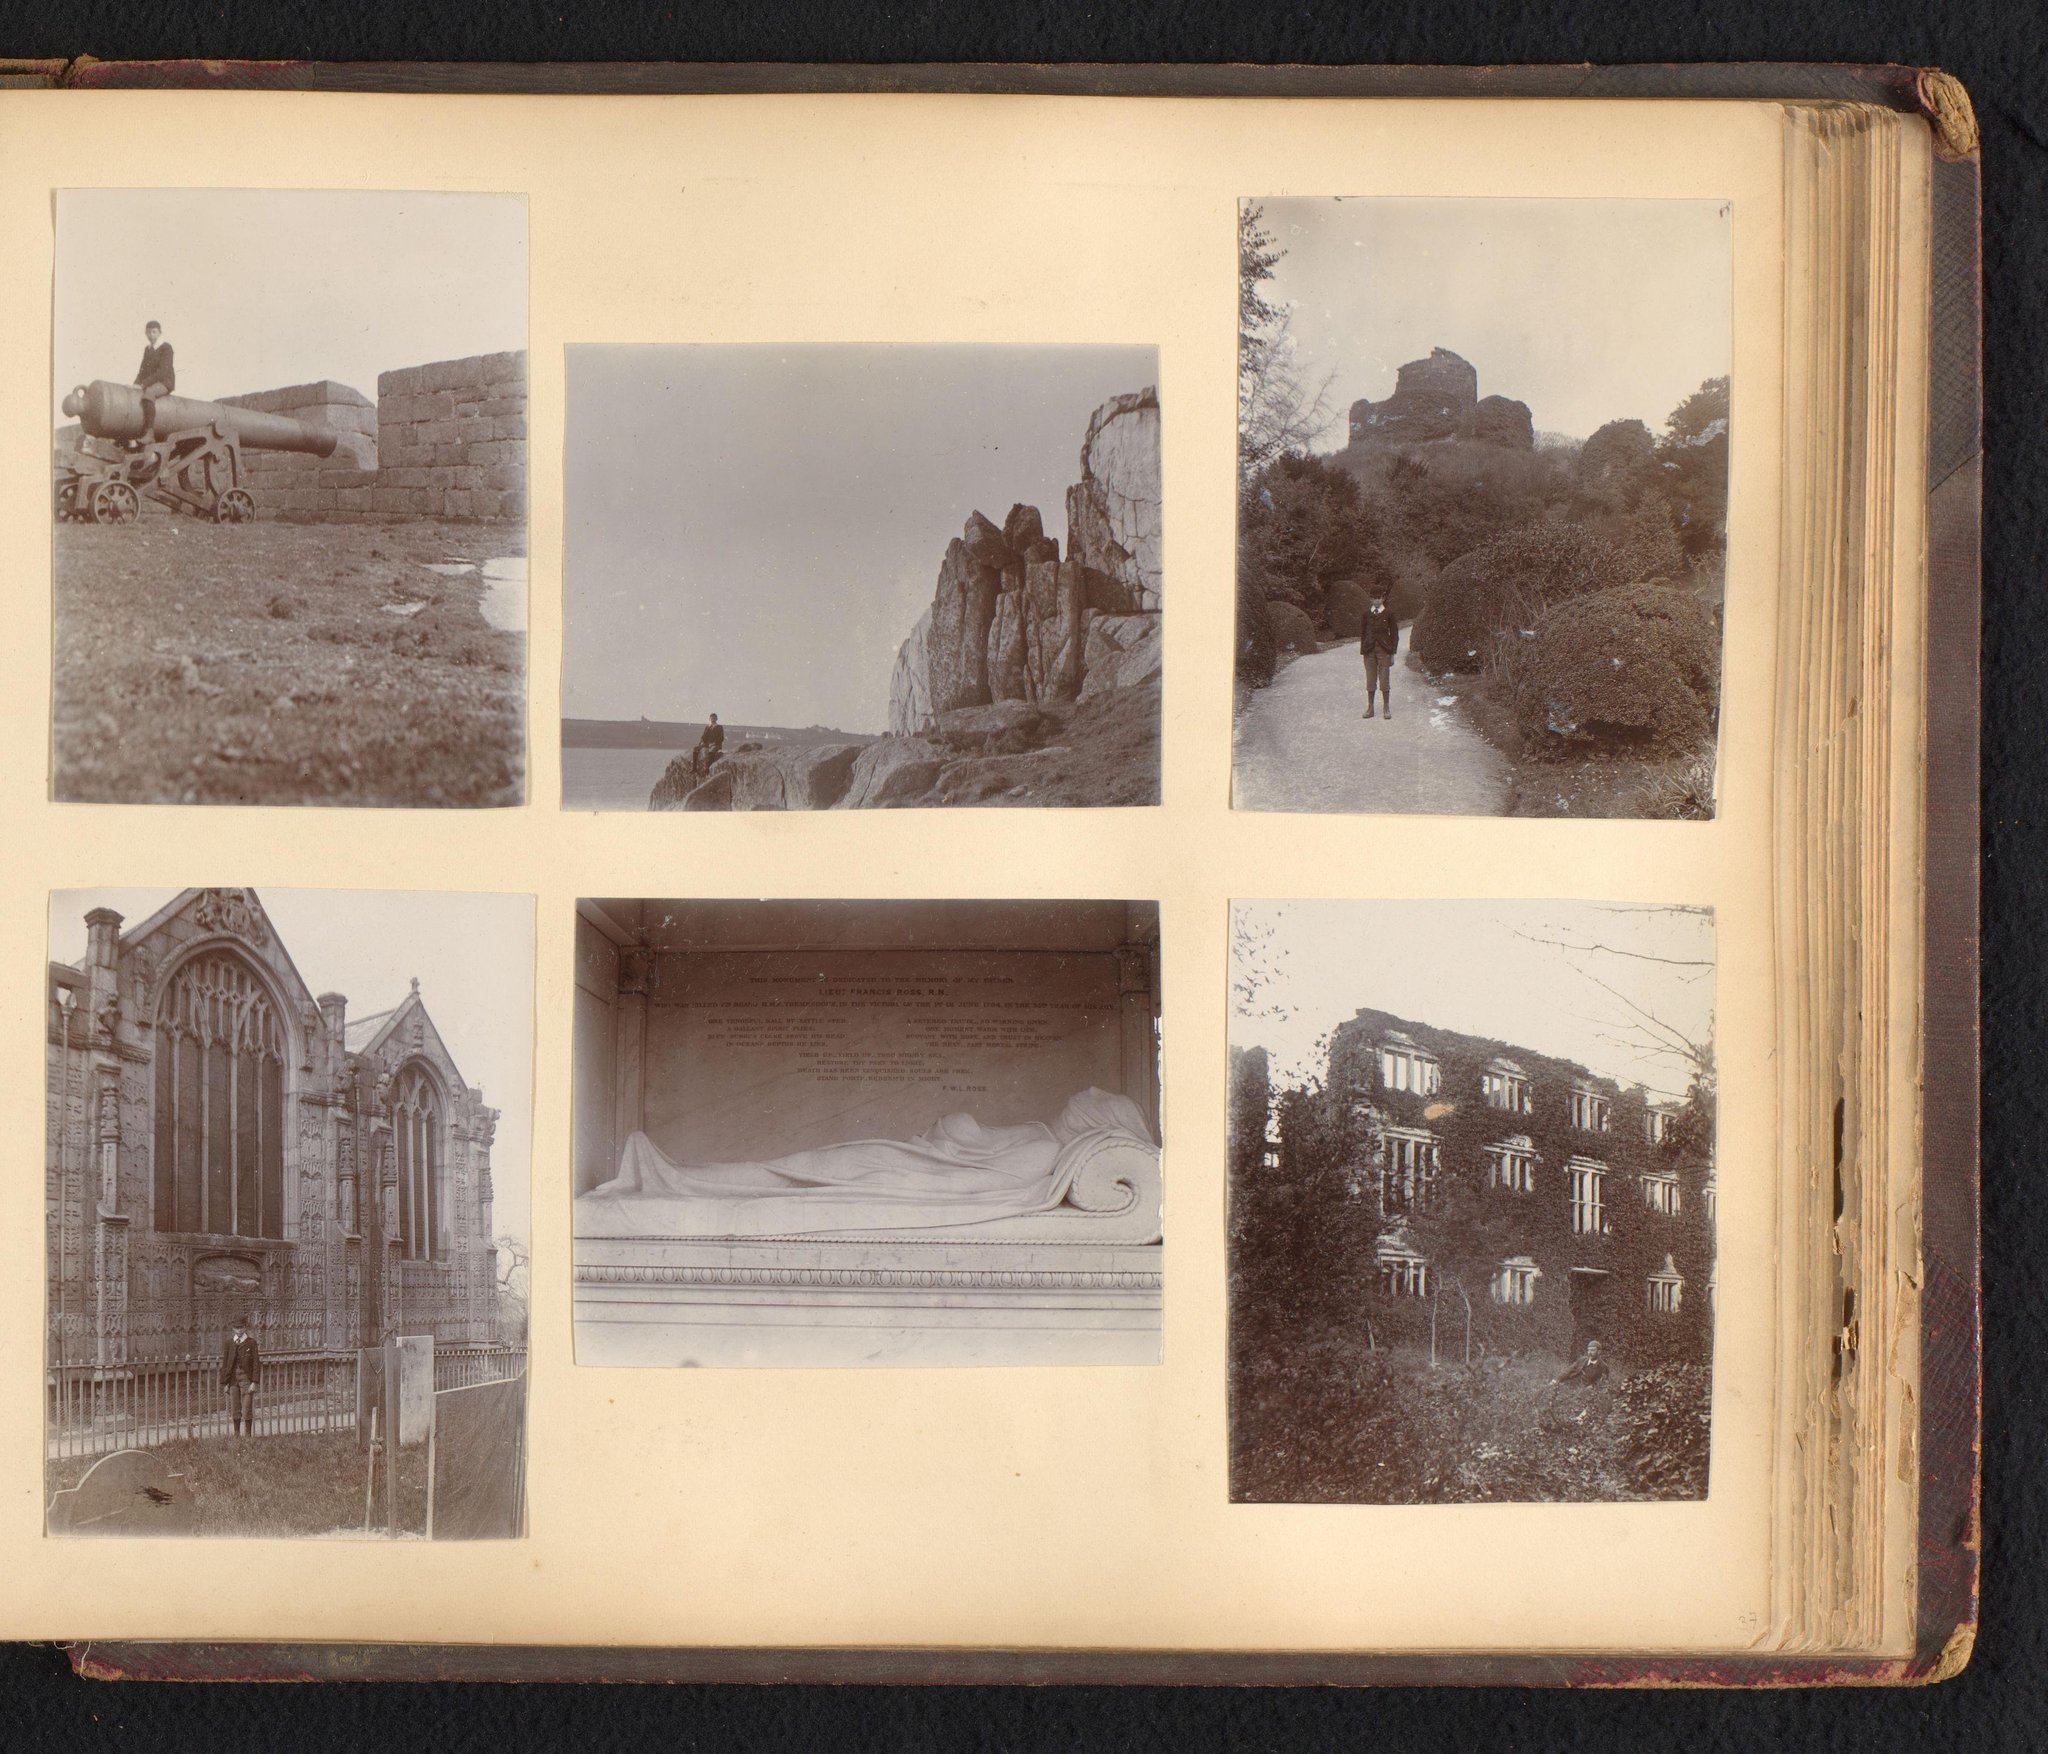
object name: photograph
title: Diverse onderwerpen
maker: Anonymous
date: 1890-1898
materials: photographic support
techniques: collodion silver print, gelatin silver print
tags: youth, adolescent, church (exterior), monument, statue, forest path or lane, rocks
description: Jongen bij een kanon, op een rots, op een bospad en bij een kerk, een man in een tuin en een monument. Deze pagina maakt deel uit van een album.